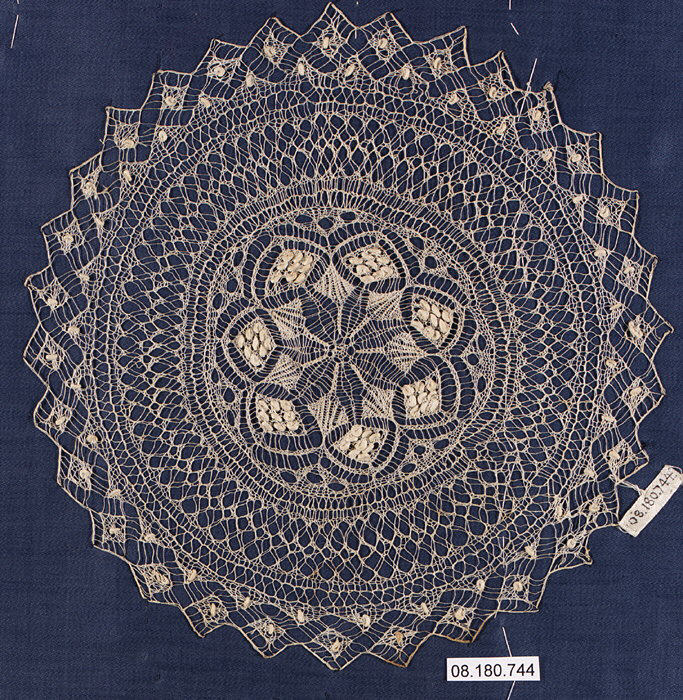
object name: doily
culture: paraguayan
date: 1801-1900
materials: lace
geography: paraguay